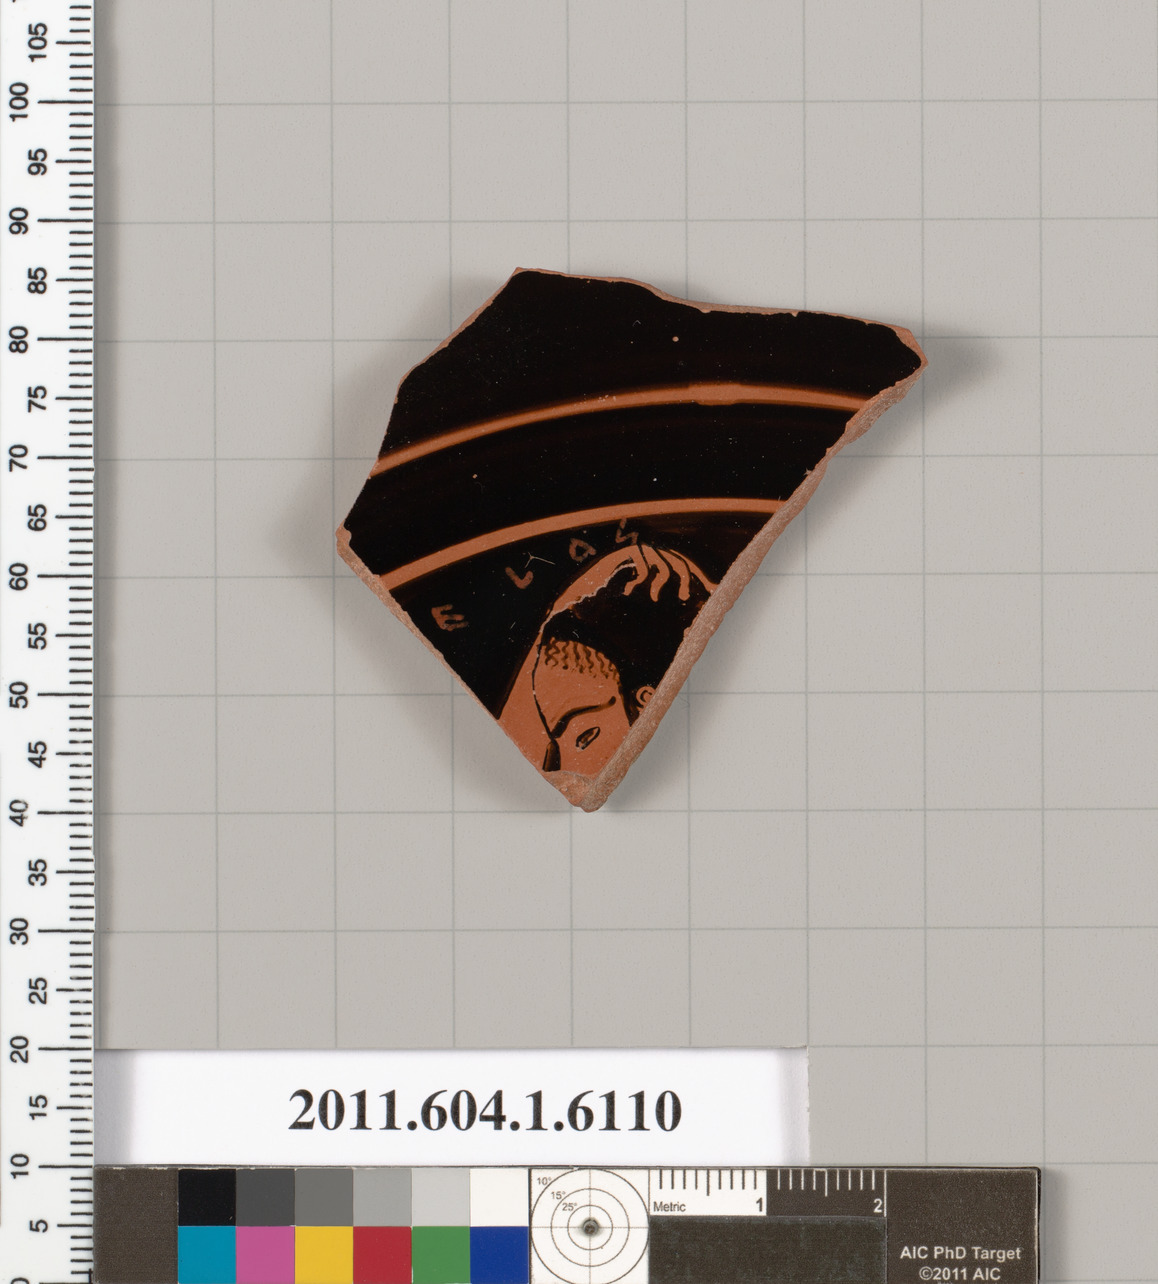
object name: kylix fragment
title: Terracotta fragment of a kylix (drinking cup)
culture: greek, attic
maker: kleomelos painter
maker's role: artist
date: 520-500 BCE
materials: terracotta